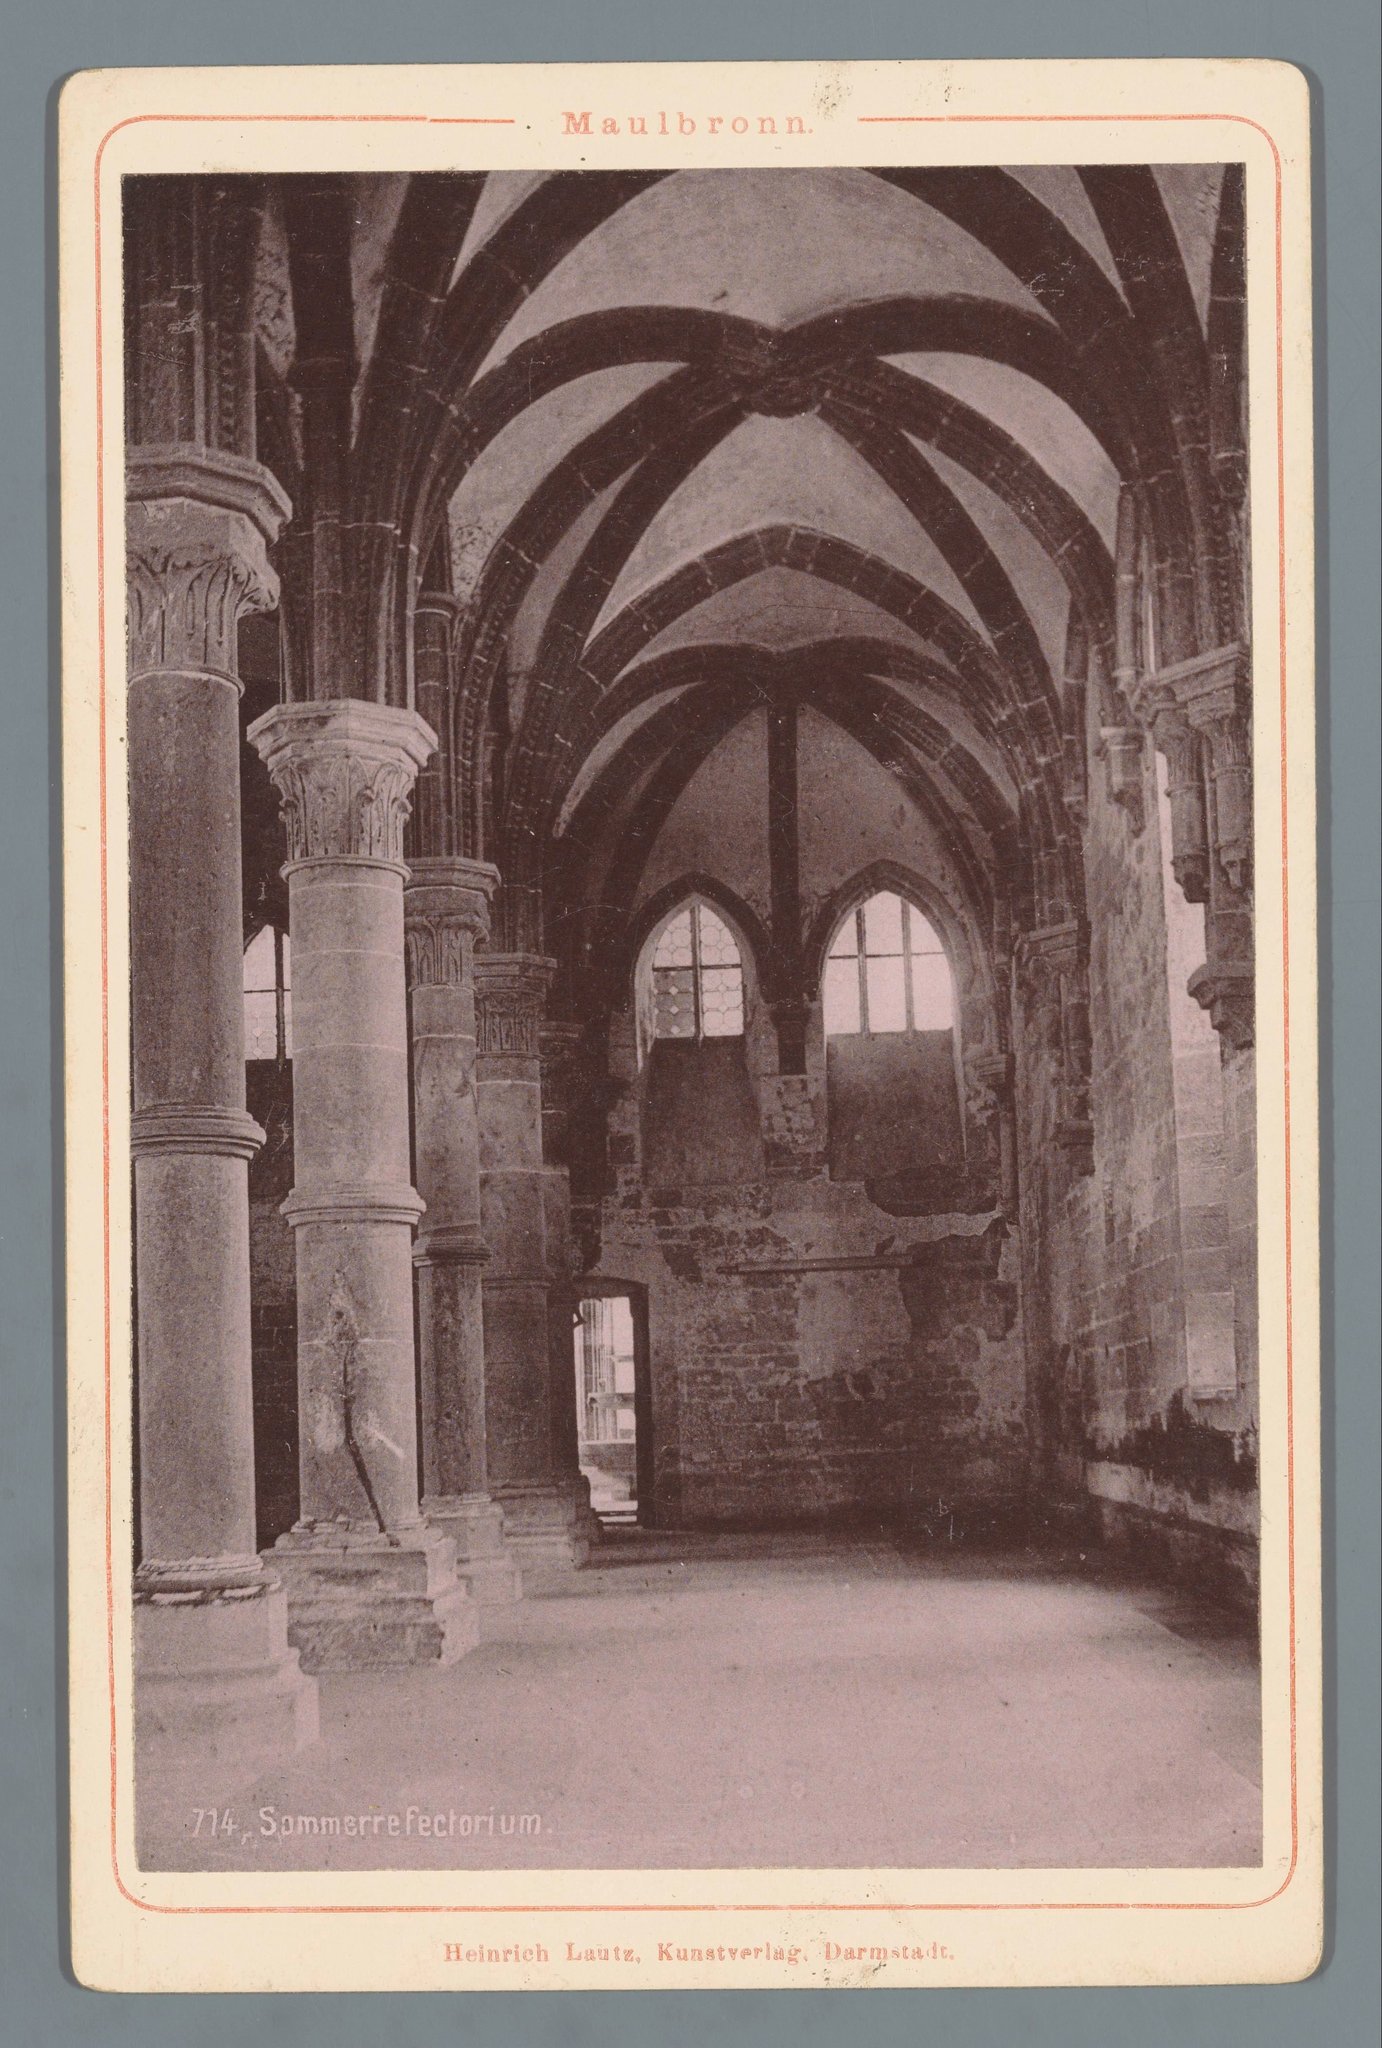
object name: photomechanical print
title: Sommerrefectorium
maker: Anonymous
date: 1895-1900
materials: cardboard, paper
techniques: photograph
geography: darmstadt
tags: refectory ~ monastery, abbey, monastery, convent ~ roman catholic church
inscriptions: number: ‘714’, inscription: ‘17 Juli 1894.’